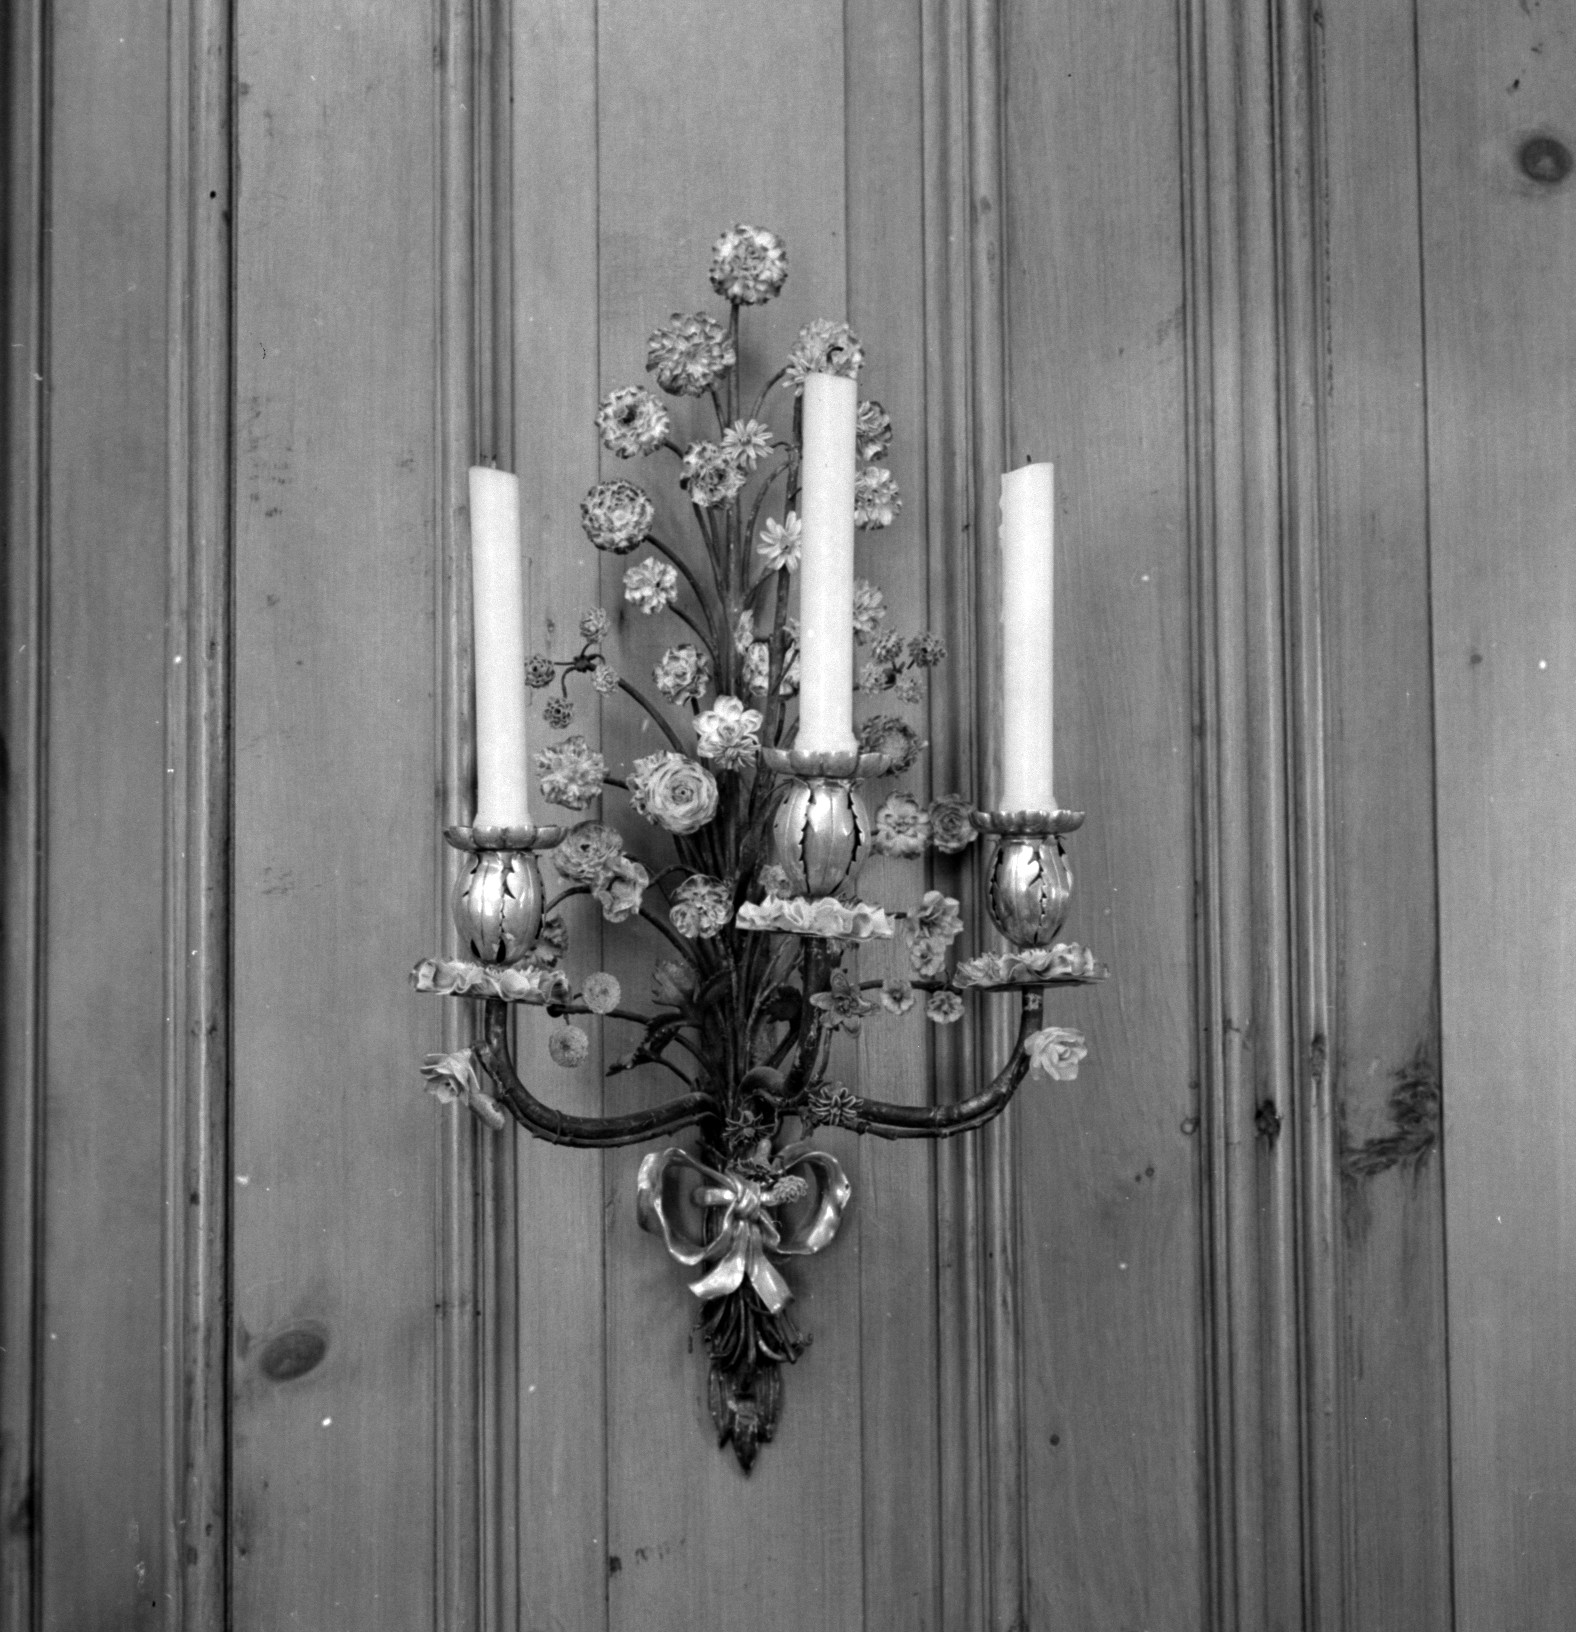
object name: wall bracket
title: Pair of three-light wall brackets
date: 1770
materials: gilt bronze, metal, porcelain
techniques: painting